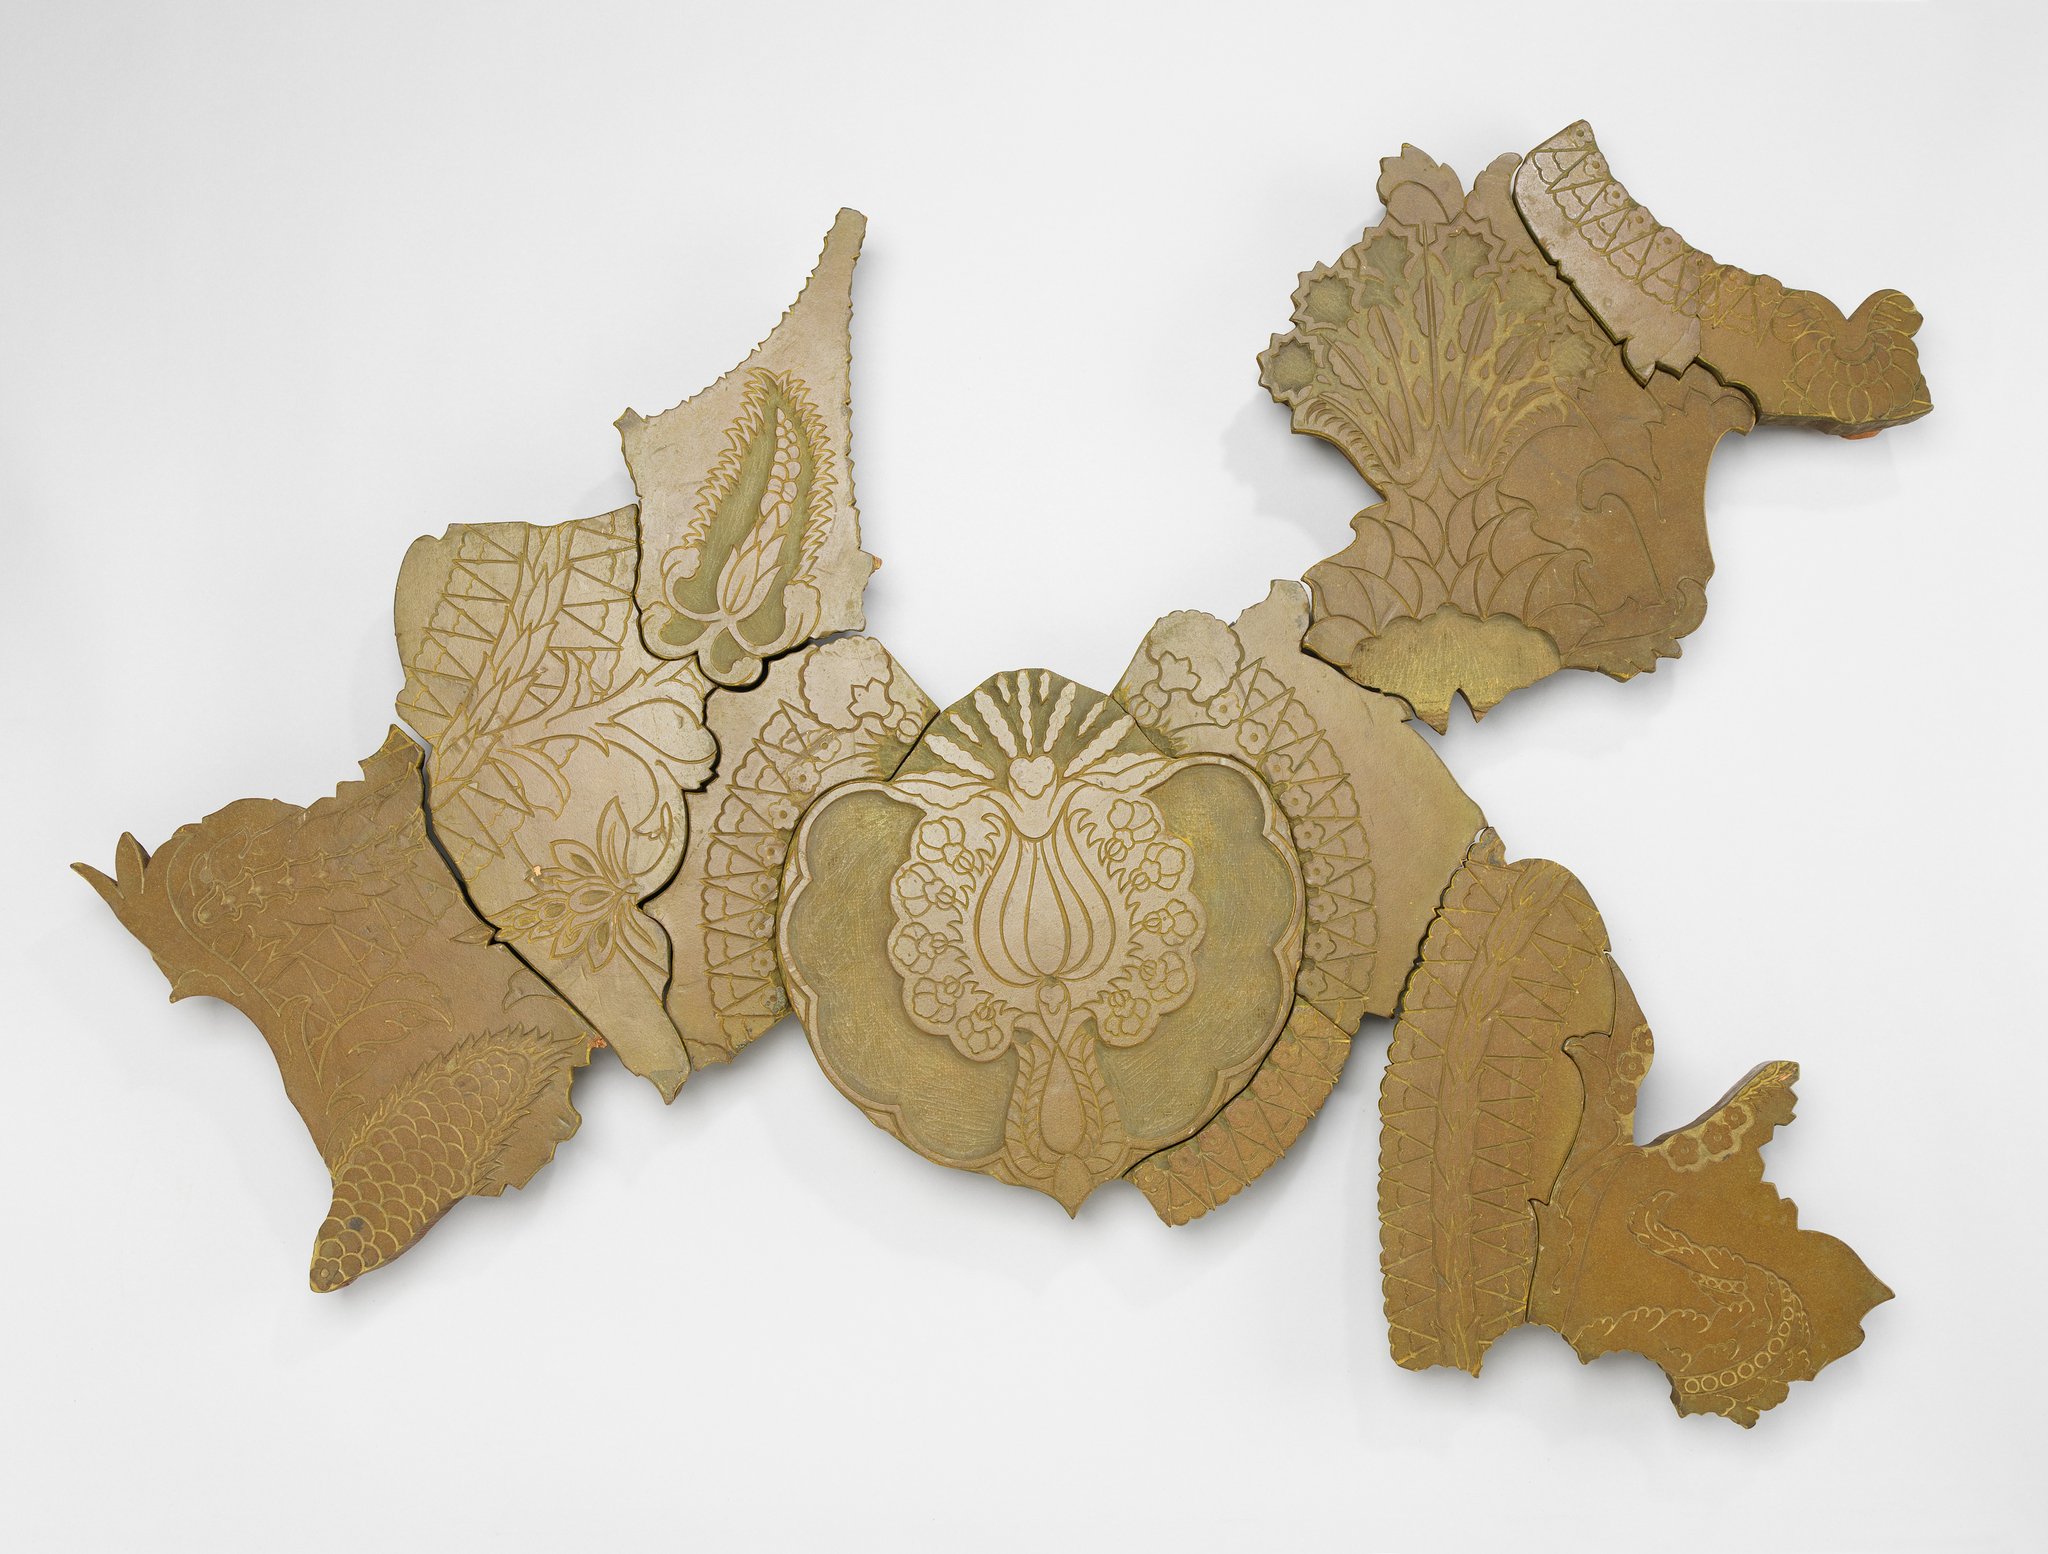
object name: equipment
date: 1801-1900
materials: wood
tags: flowers